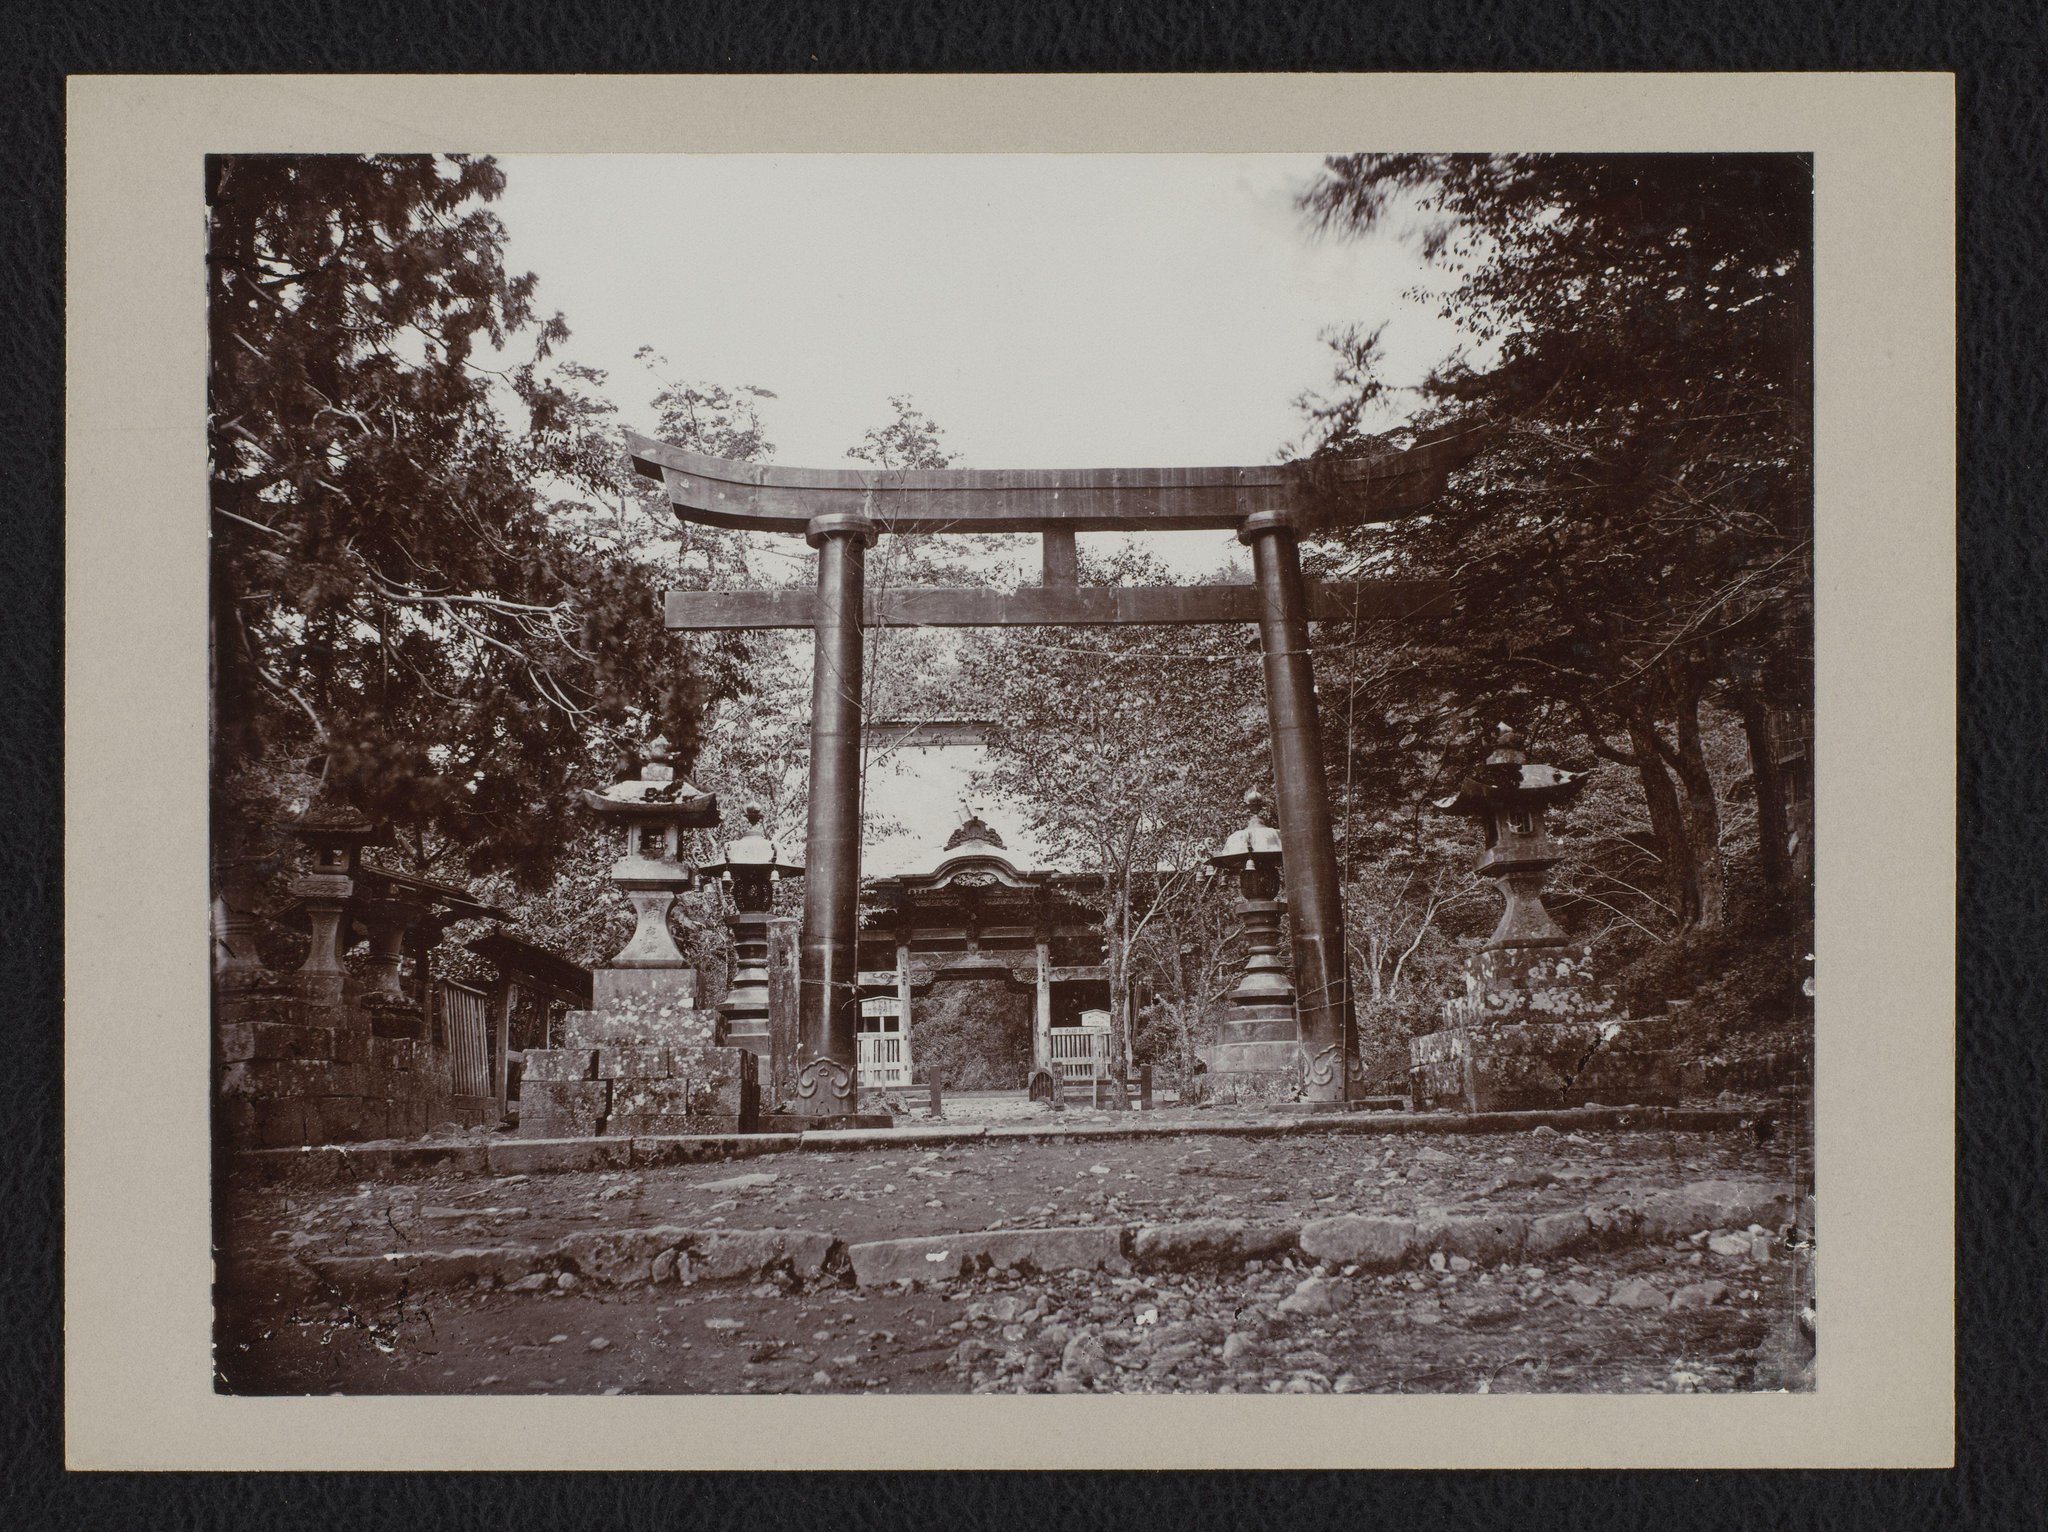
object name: photograph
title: Torri, Ikaho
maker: Anonymous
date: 1895-1915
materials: cardboard, photographic support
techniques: collodion silver print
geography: ikaho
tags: ikaho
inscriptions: annotation: ‘43. Ikao.’